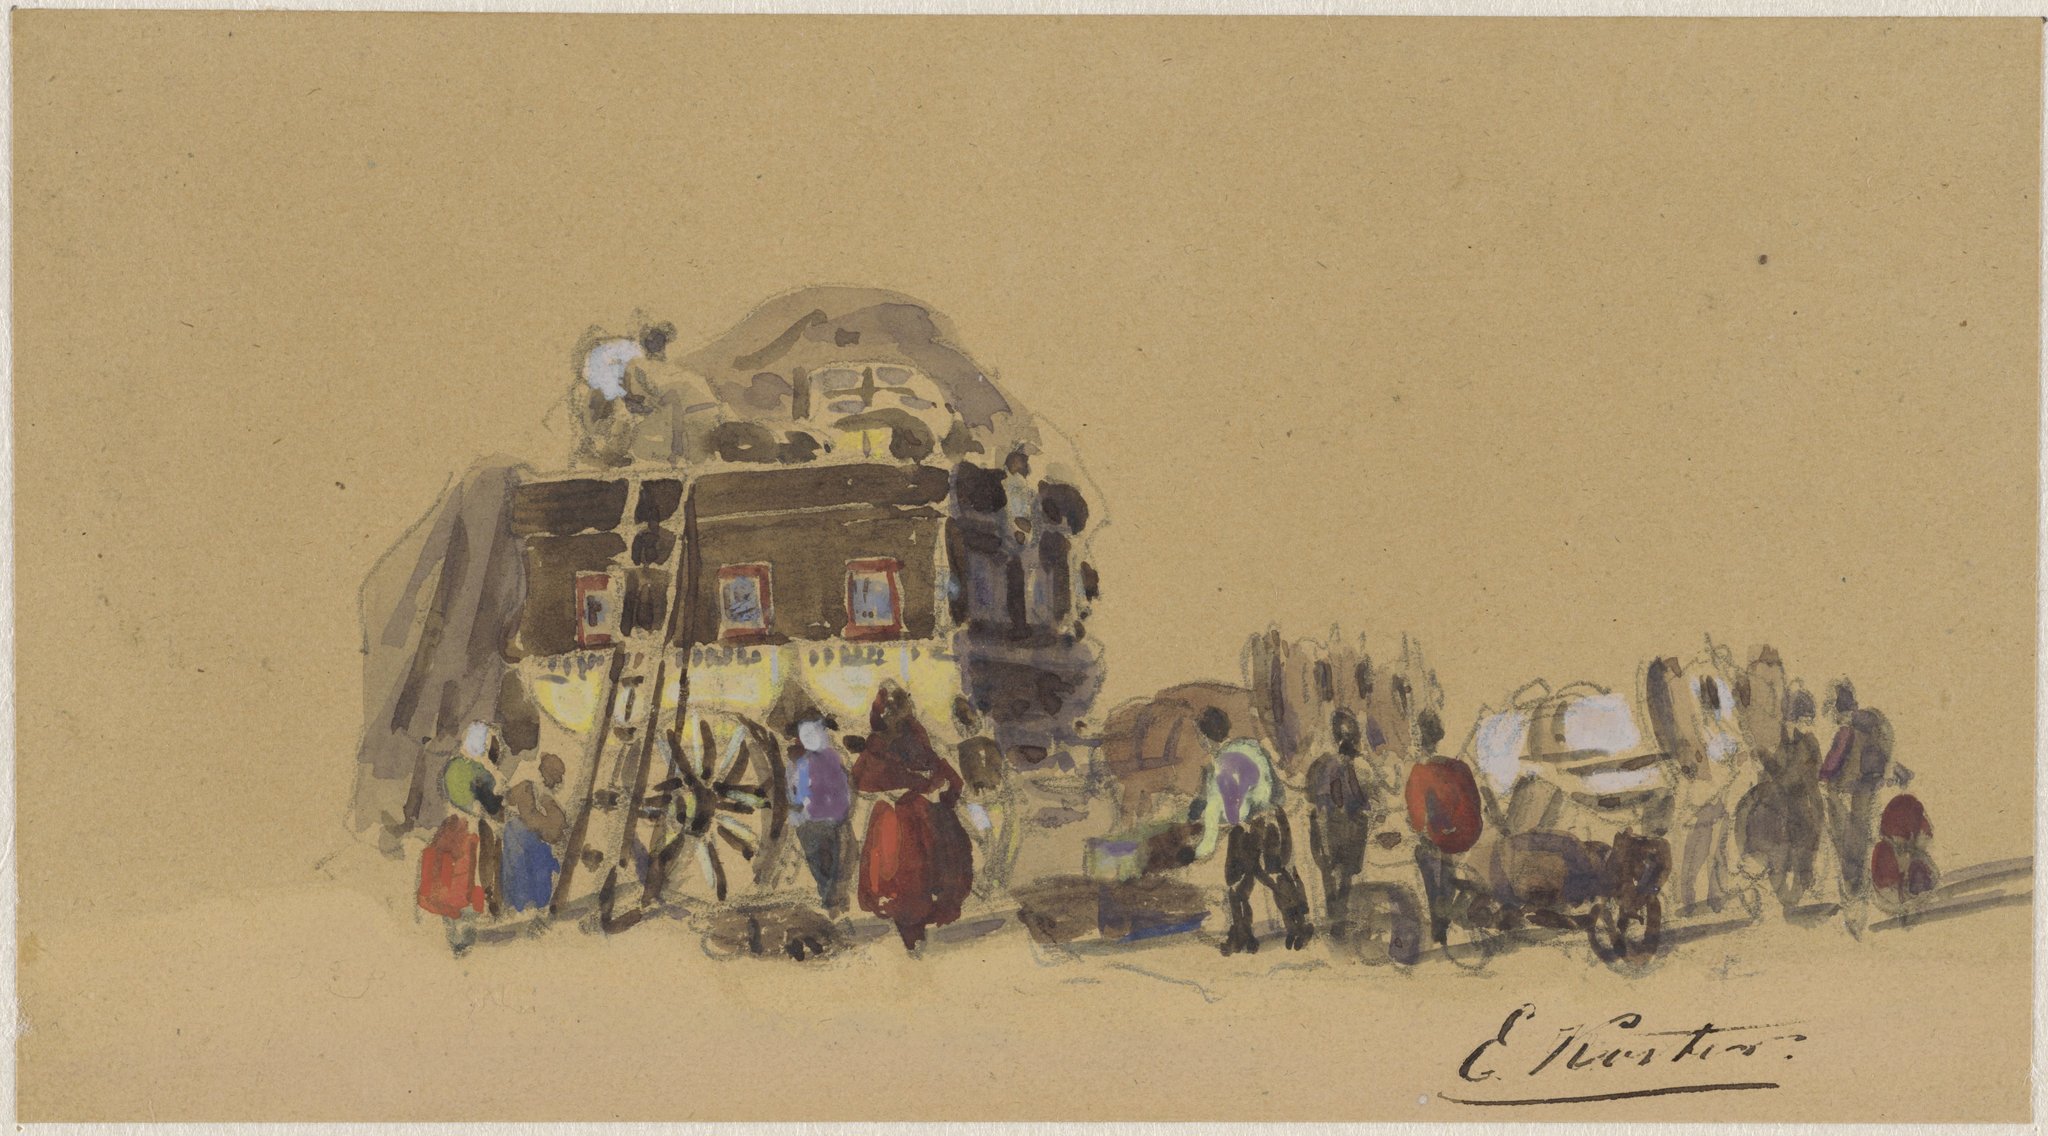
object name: drawing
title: Het opladen van een reiswagen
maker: everhardus koster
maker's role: draughtsman, painter, print maker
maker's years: 1817-1892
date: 1827-1892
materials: paper, pencil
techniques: brush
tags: preparations ~ travelling, four-wheeled, animal-drawn vehicle, e.g.: cab, carriage, coach